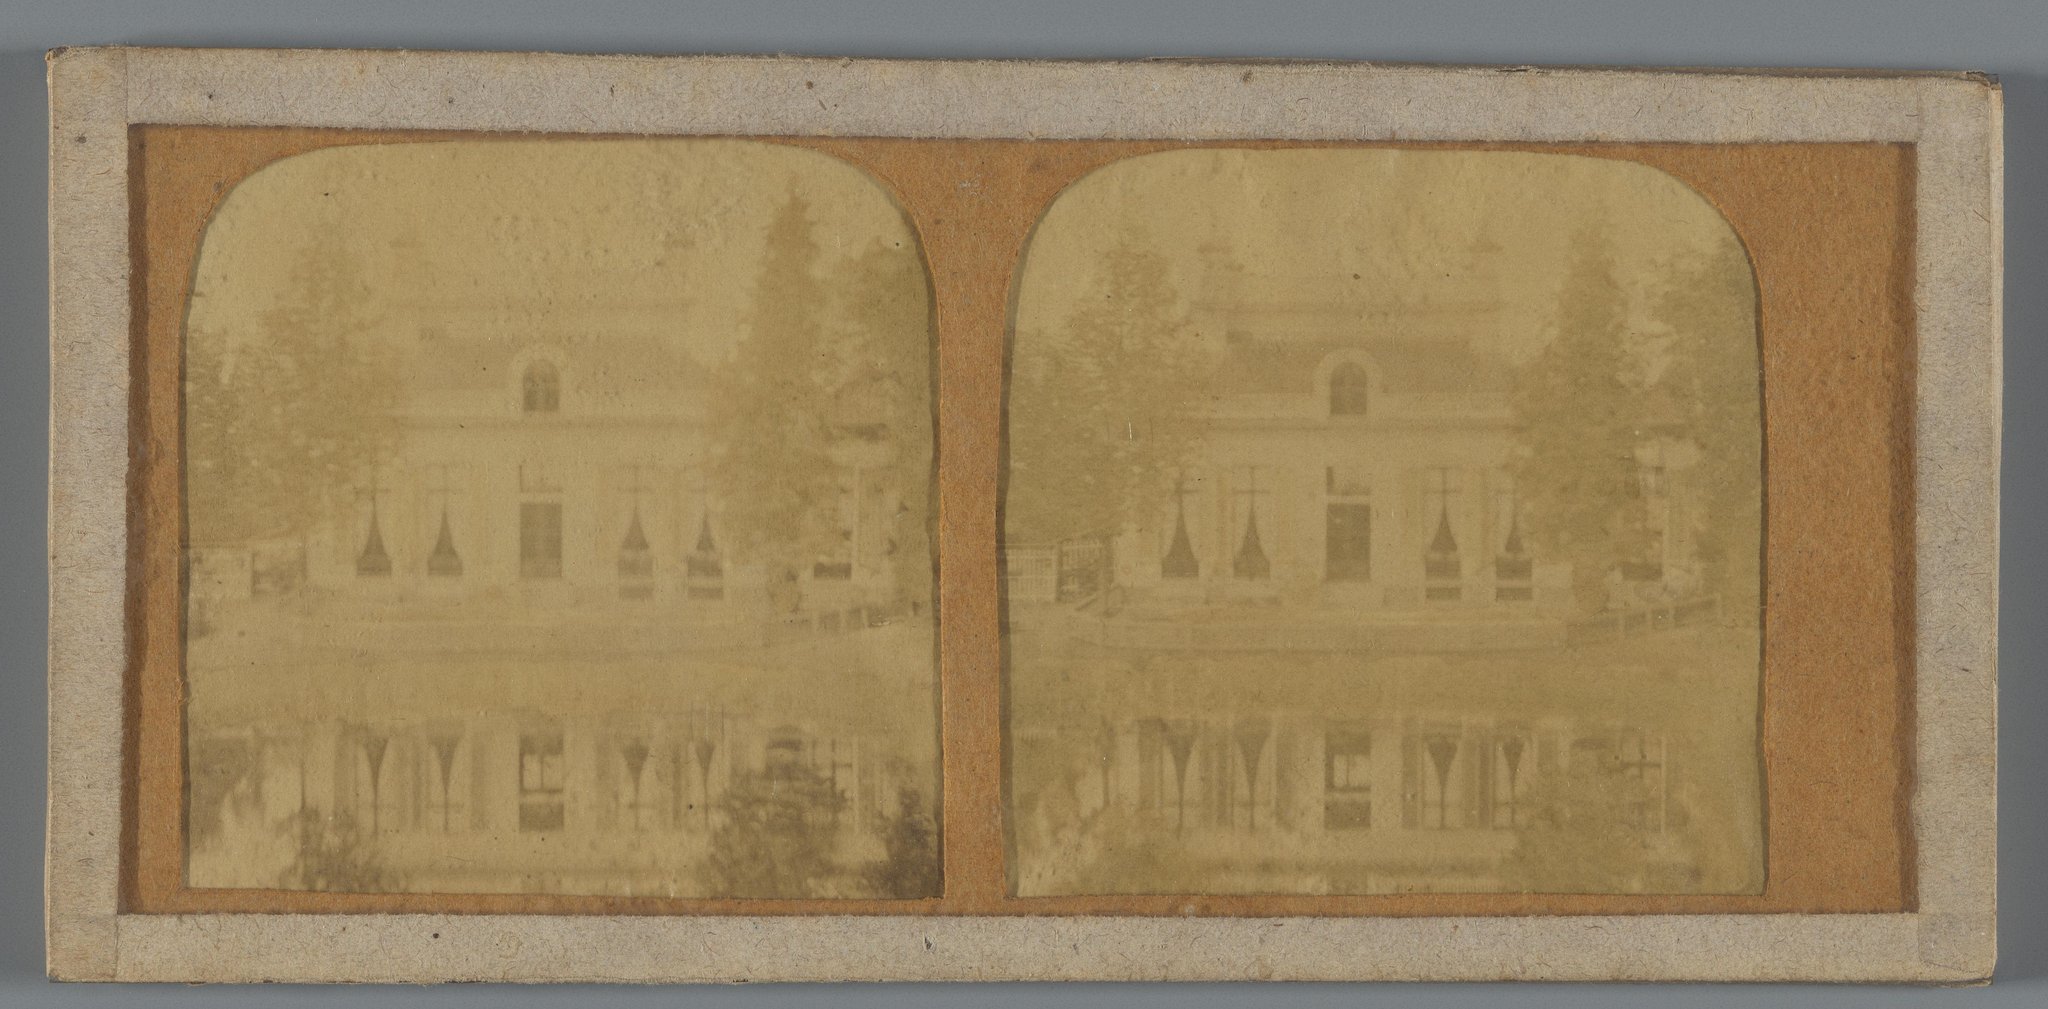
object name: tissue stereograph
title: Gezicht op een landhuis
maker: Anonymous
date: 1855-1885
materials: cardboard, glass, paper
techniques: albumen print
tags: villa